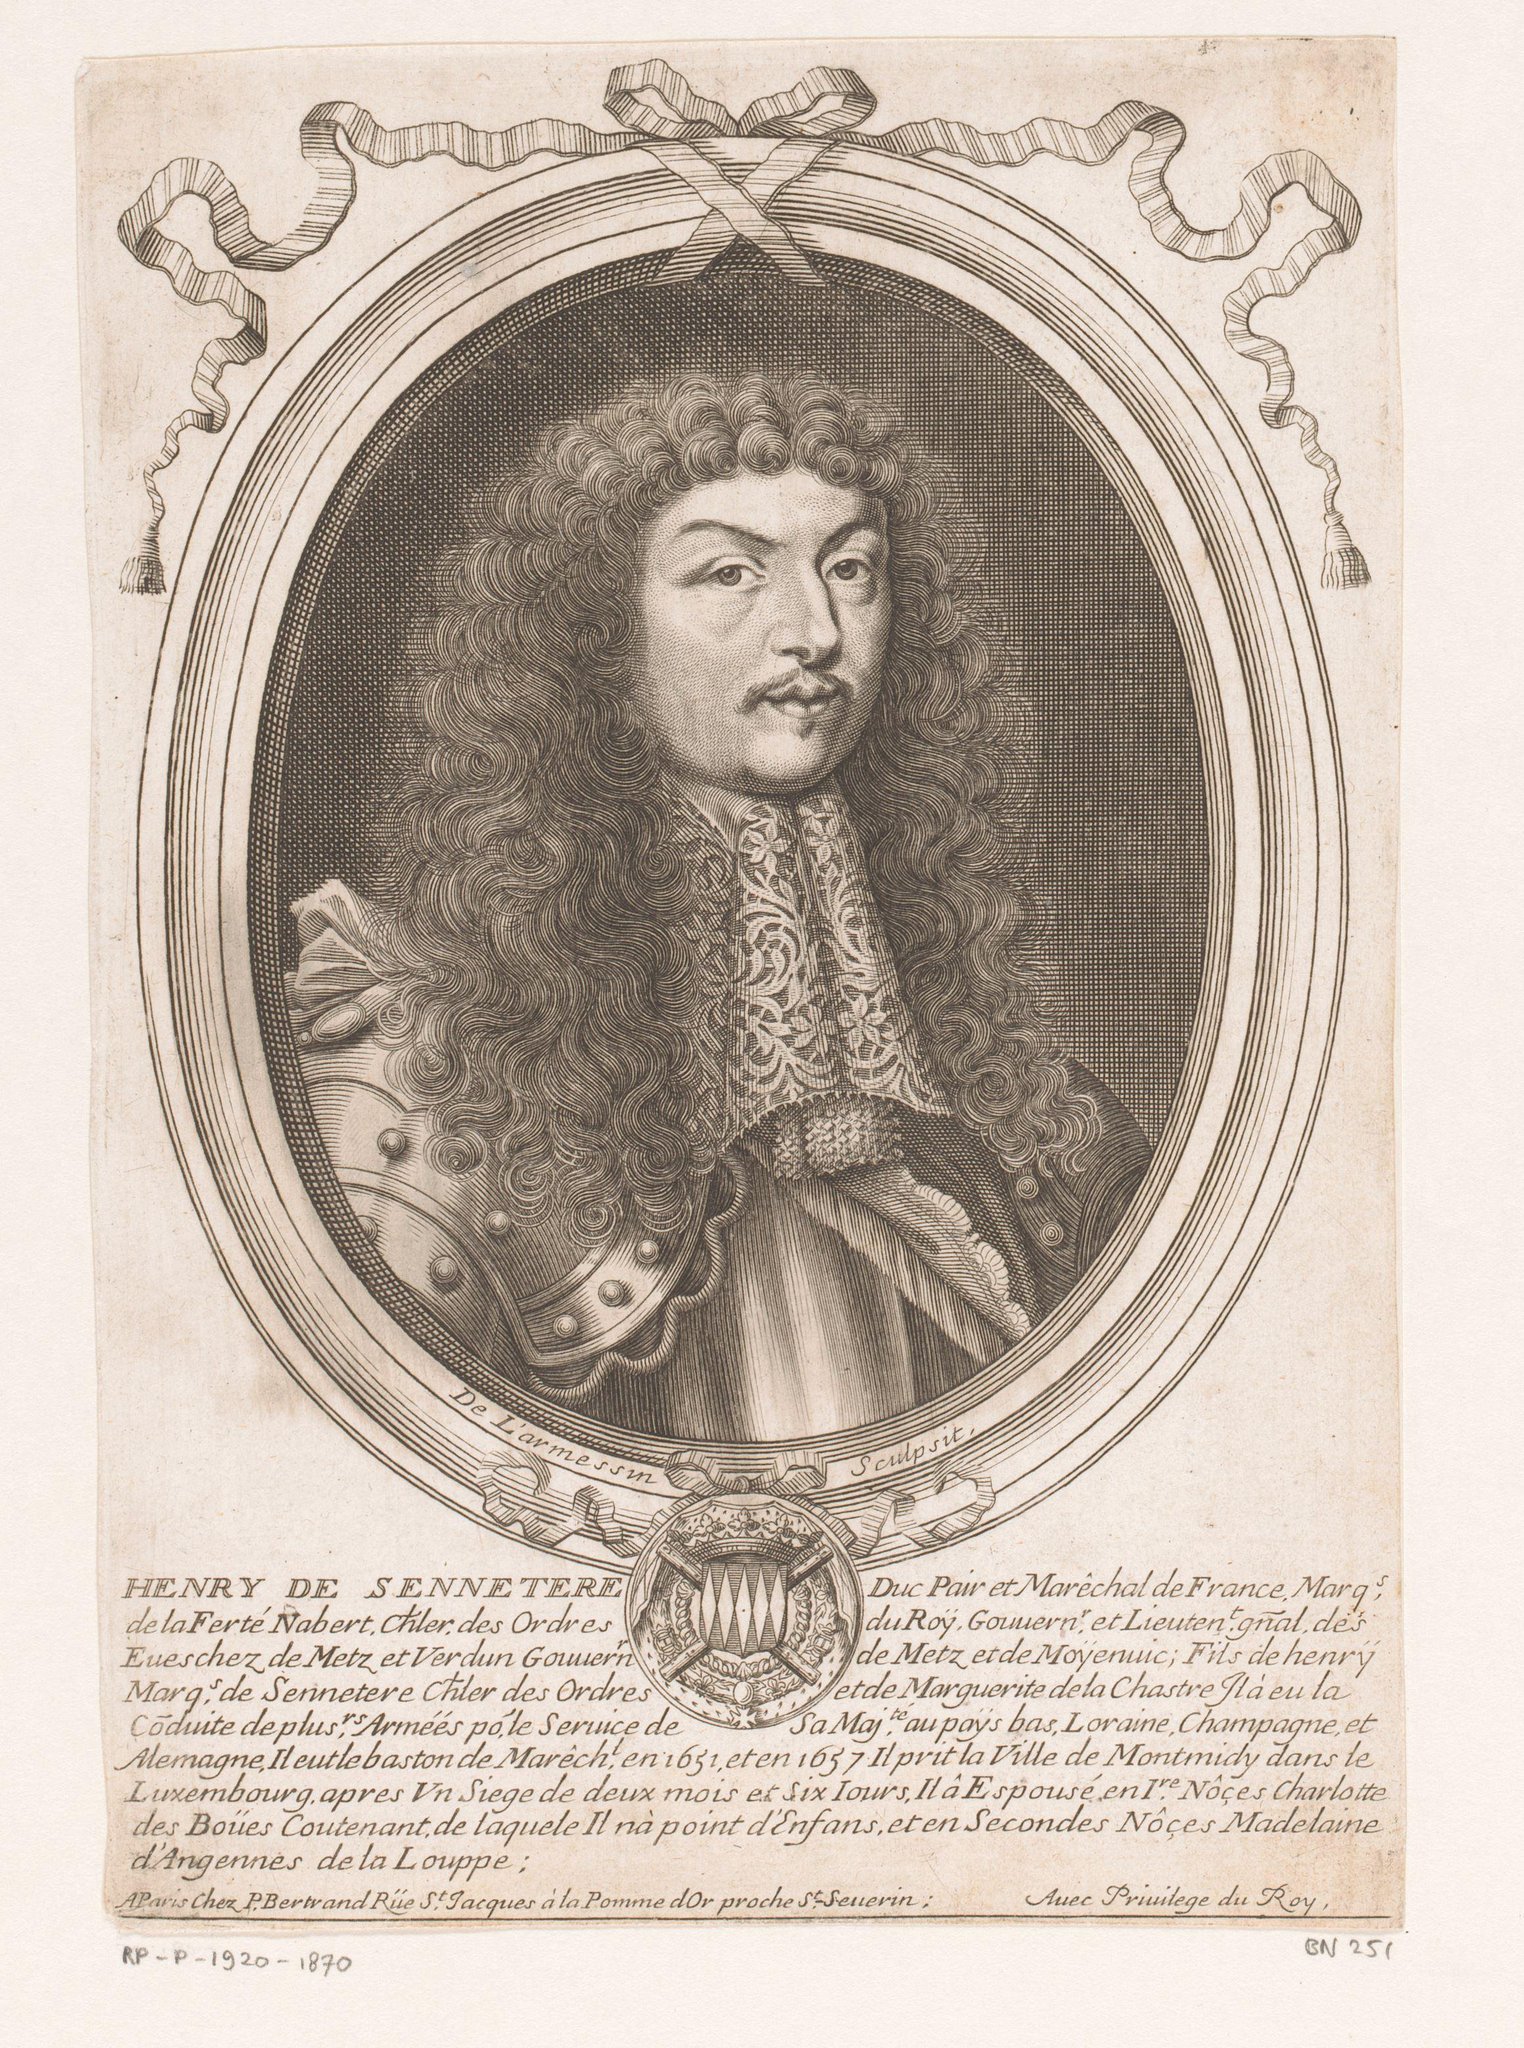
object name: print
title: Portretten van prominente figuren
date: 1642-1678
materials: paper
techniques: engraving, etching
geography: paris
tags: politician, historical persons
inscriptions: collector's mark: Lugt 2228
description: Maakt deel uit van een grootschalige serie met portretten van prominente figuren. Binnen de serie bevindt zich een sectie getiteld 'Les Augustes Représentations De tous les Roys De France depuis Pharamond Iusqu'à Louys XIIII'. De serie werd respectievelijk uitgegeven door Pierre Bertrand, door zijn weduwe en door De Larmessin zelf.